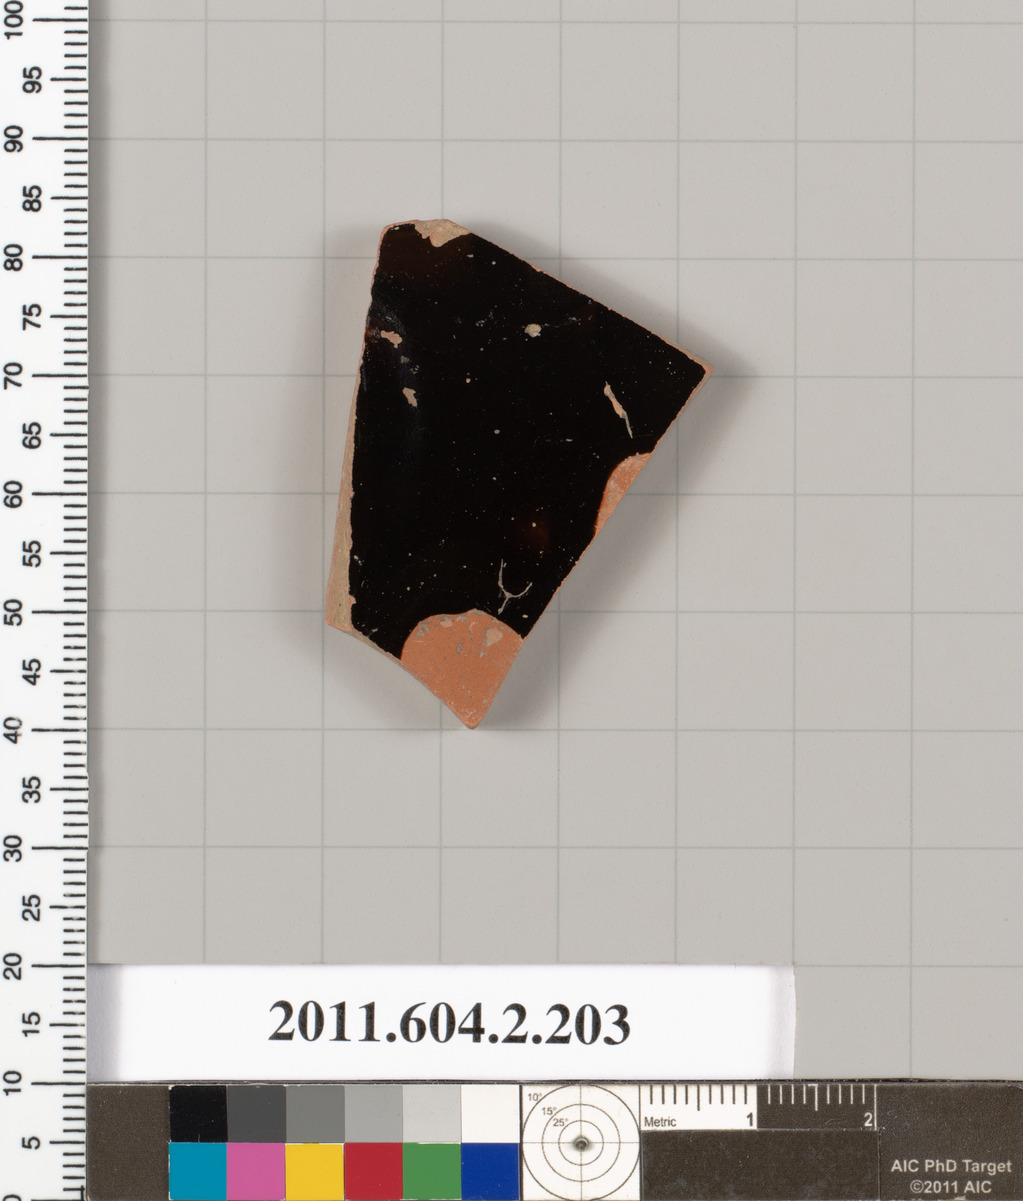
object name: stamnos fragment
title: Terracotta fragment of a stamnos (jar)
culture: greek, attic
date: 500-451 BCE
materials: terracotta